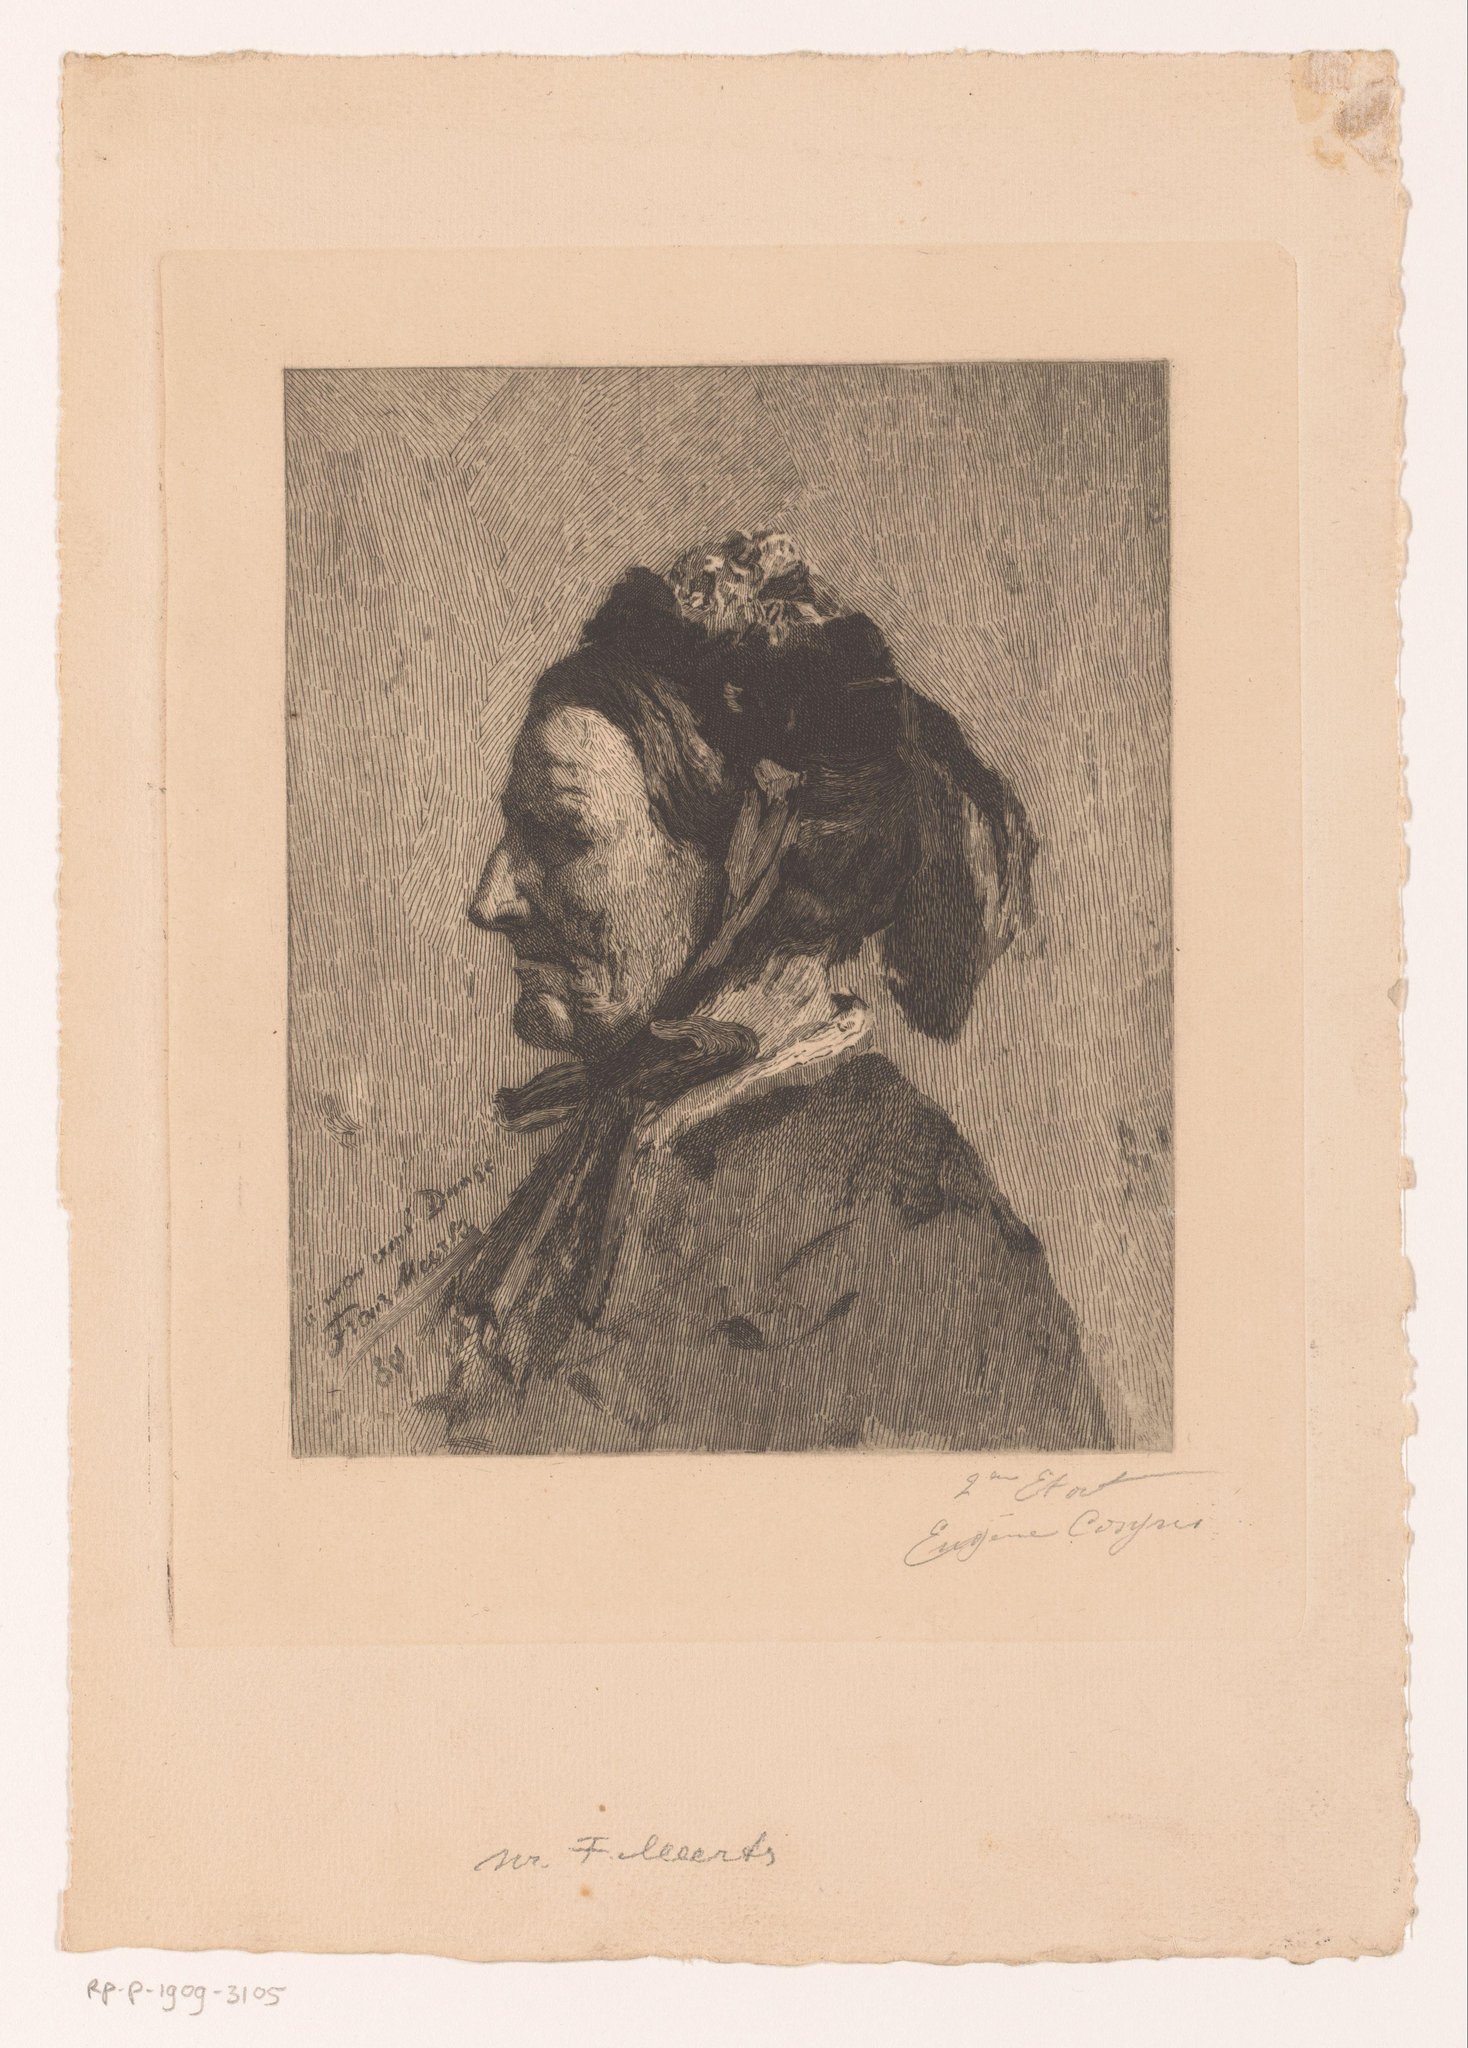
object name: print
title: Portret van een onbekende oude vrouw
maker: eugène cosyns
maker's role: print maker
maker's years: 1862-1909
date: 1880-1909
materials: paper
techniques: etching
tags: historical persons, old woman (+ sideview, profile)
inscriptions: collector's mark: Lugt 2228, inscription: ‘2em Etat’